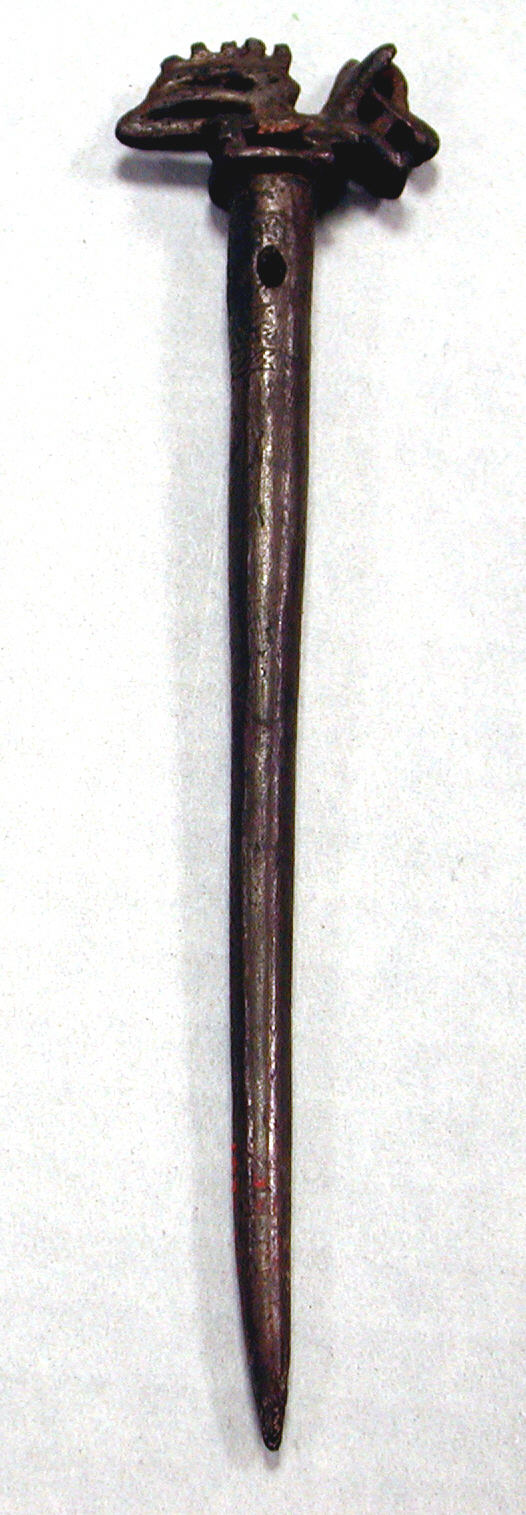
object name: knife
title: Pin with Animal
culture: moche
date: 101-700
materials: copper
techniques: casting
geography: peru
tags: animals